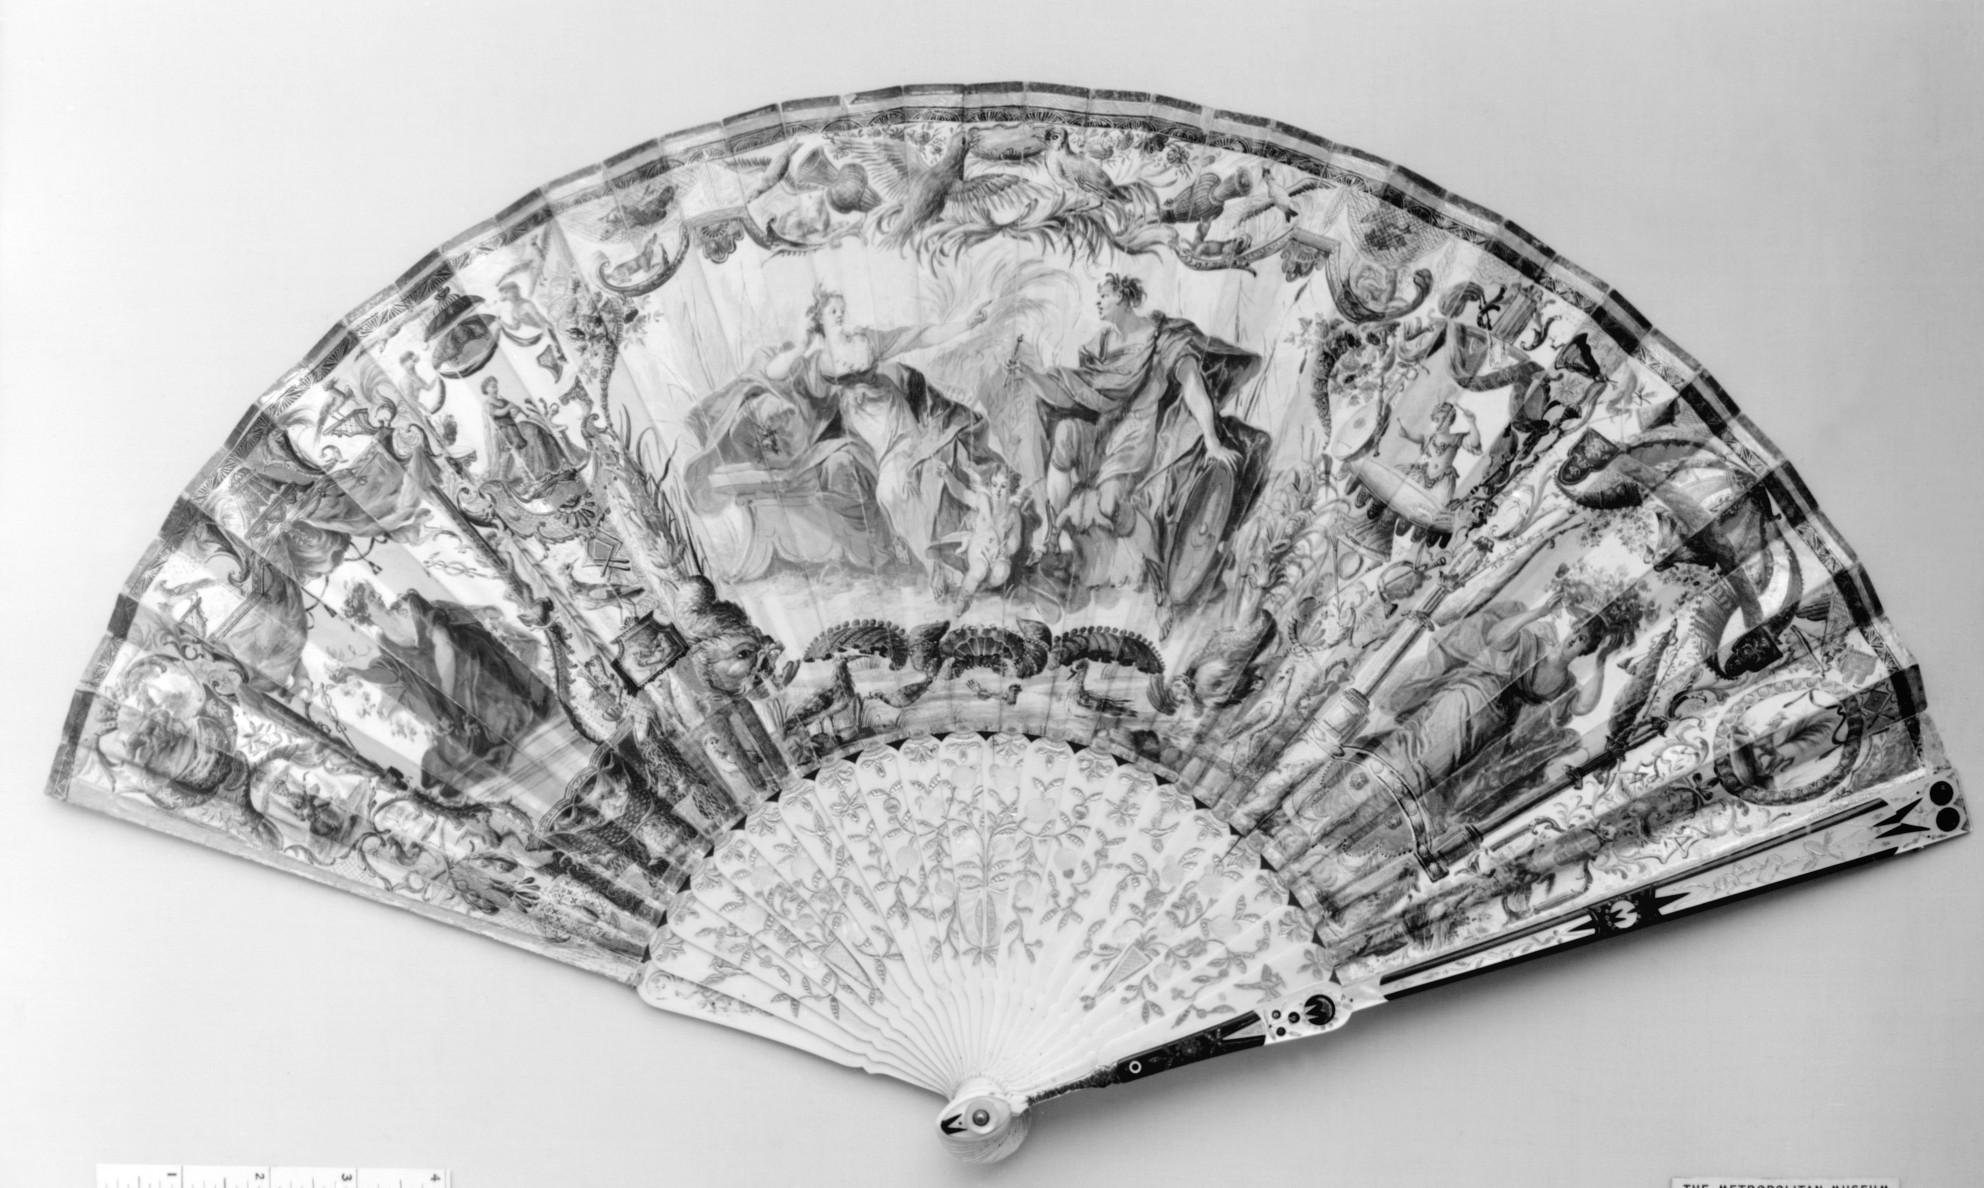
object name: fan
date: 1701-1733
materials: gold, ivory, mother of pearl, paper, shell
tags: birds,men,women